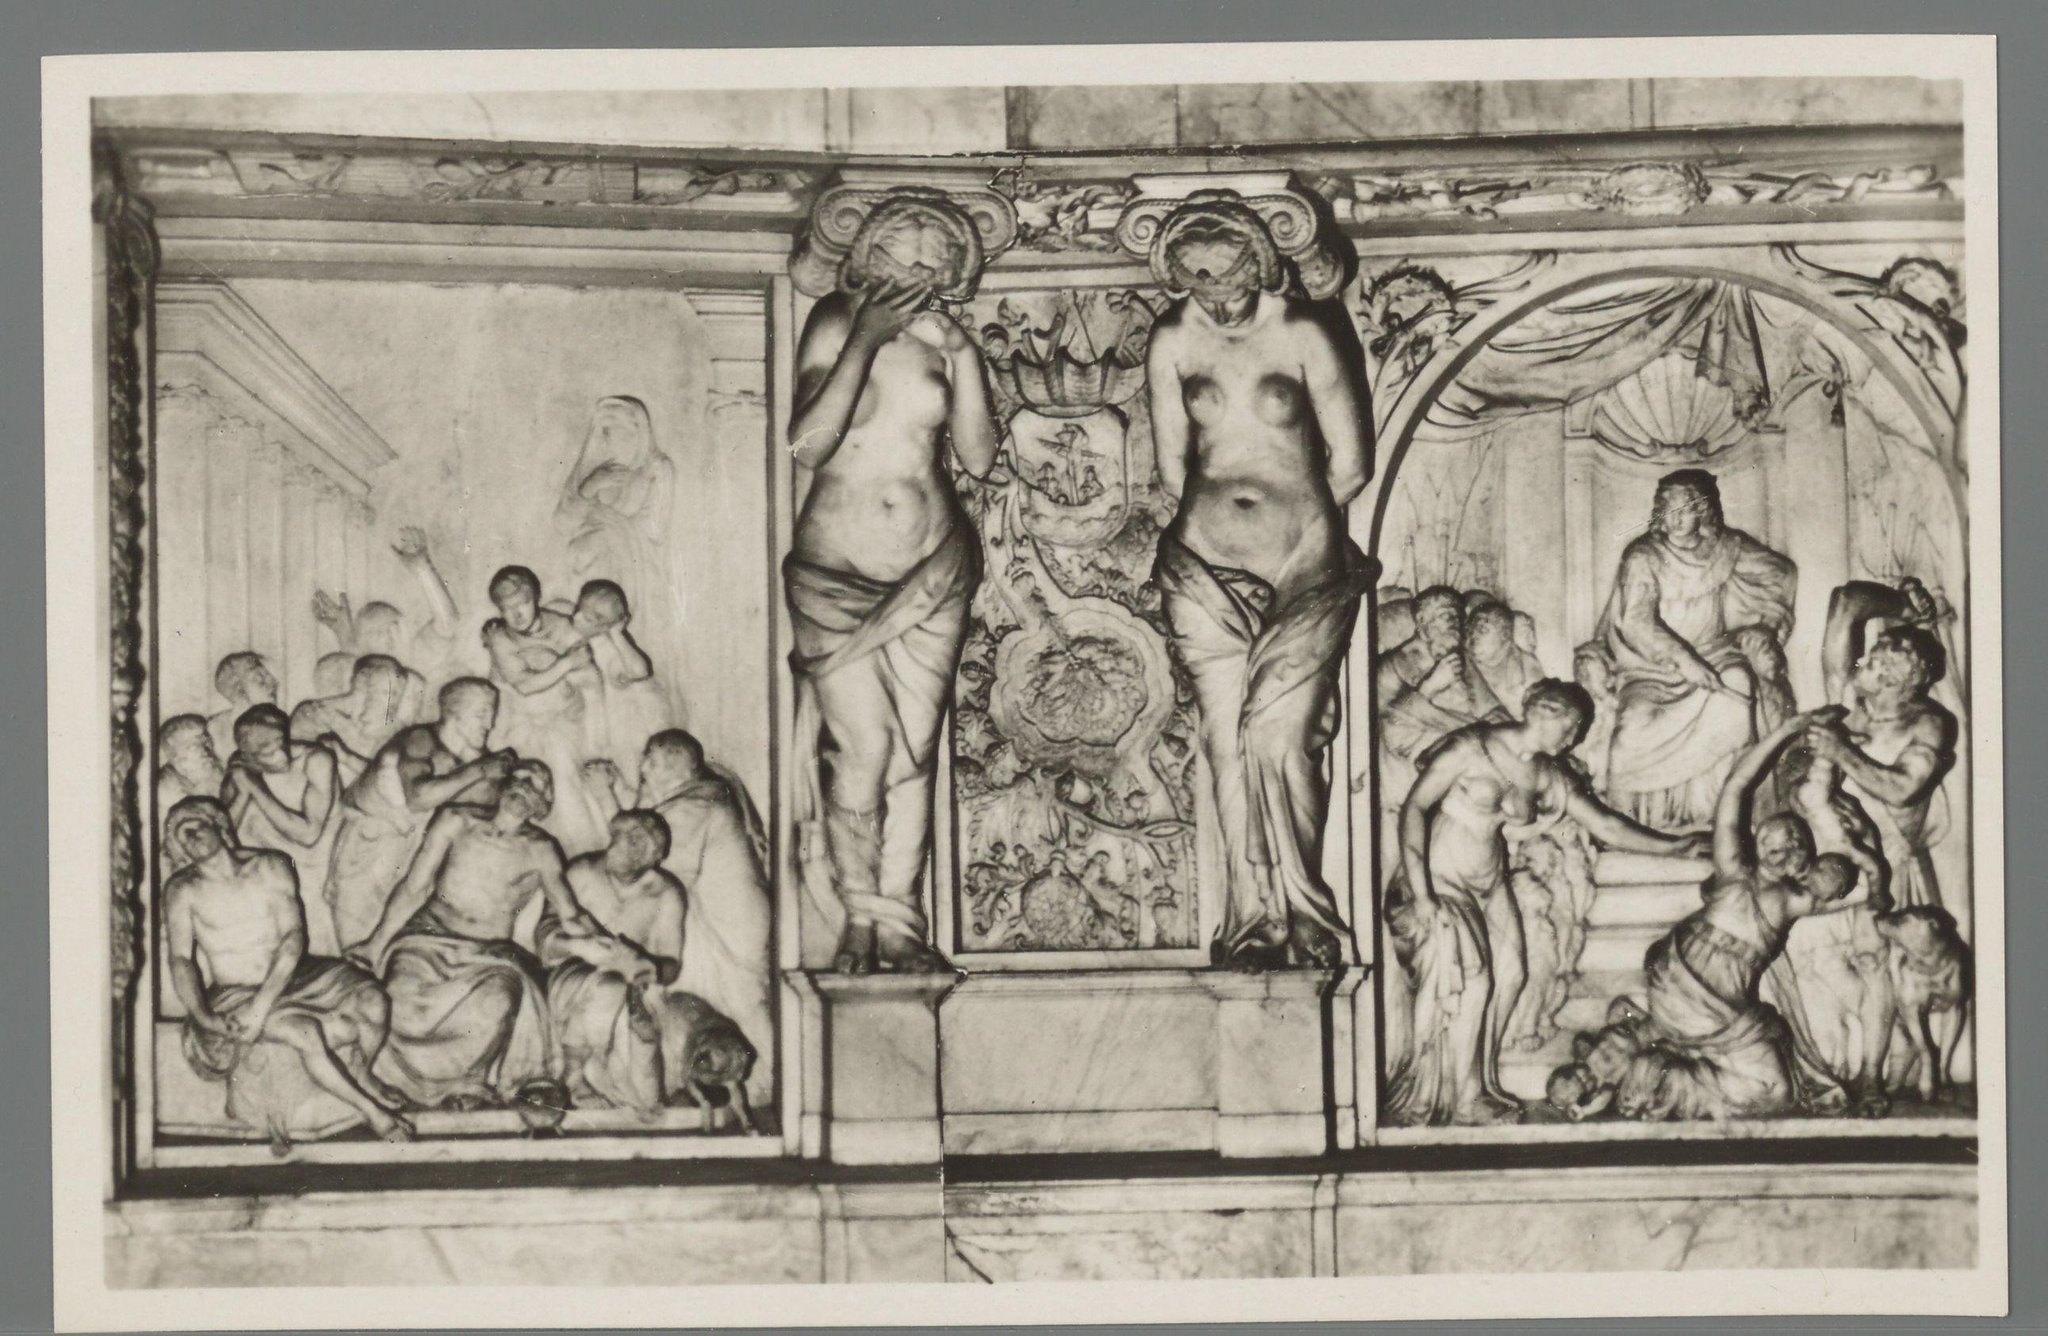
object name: photograph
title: Marmer relief. Consul Seluvkes (...) laat (...) zichzelf en zijn zoon ieder een oog uitbranden (...)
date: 1932-1947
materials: photographic support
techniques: photography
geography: the hague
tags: palace - aa - civic architecture: inside, decorations (interior of the house), sculpture, royal palace of amsterdam